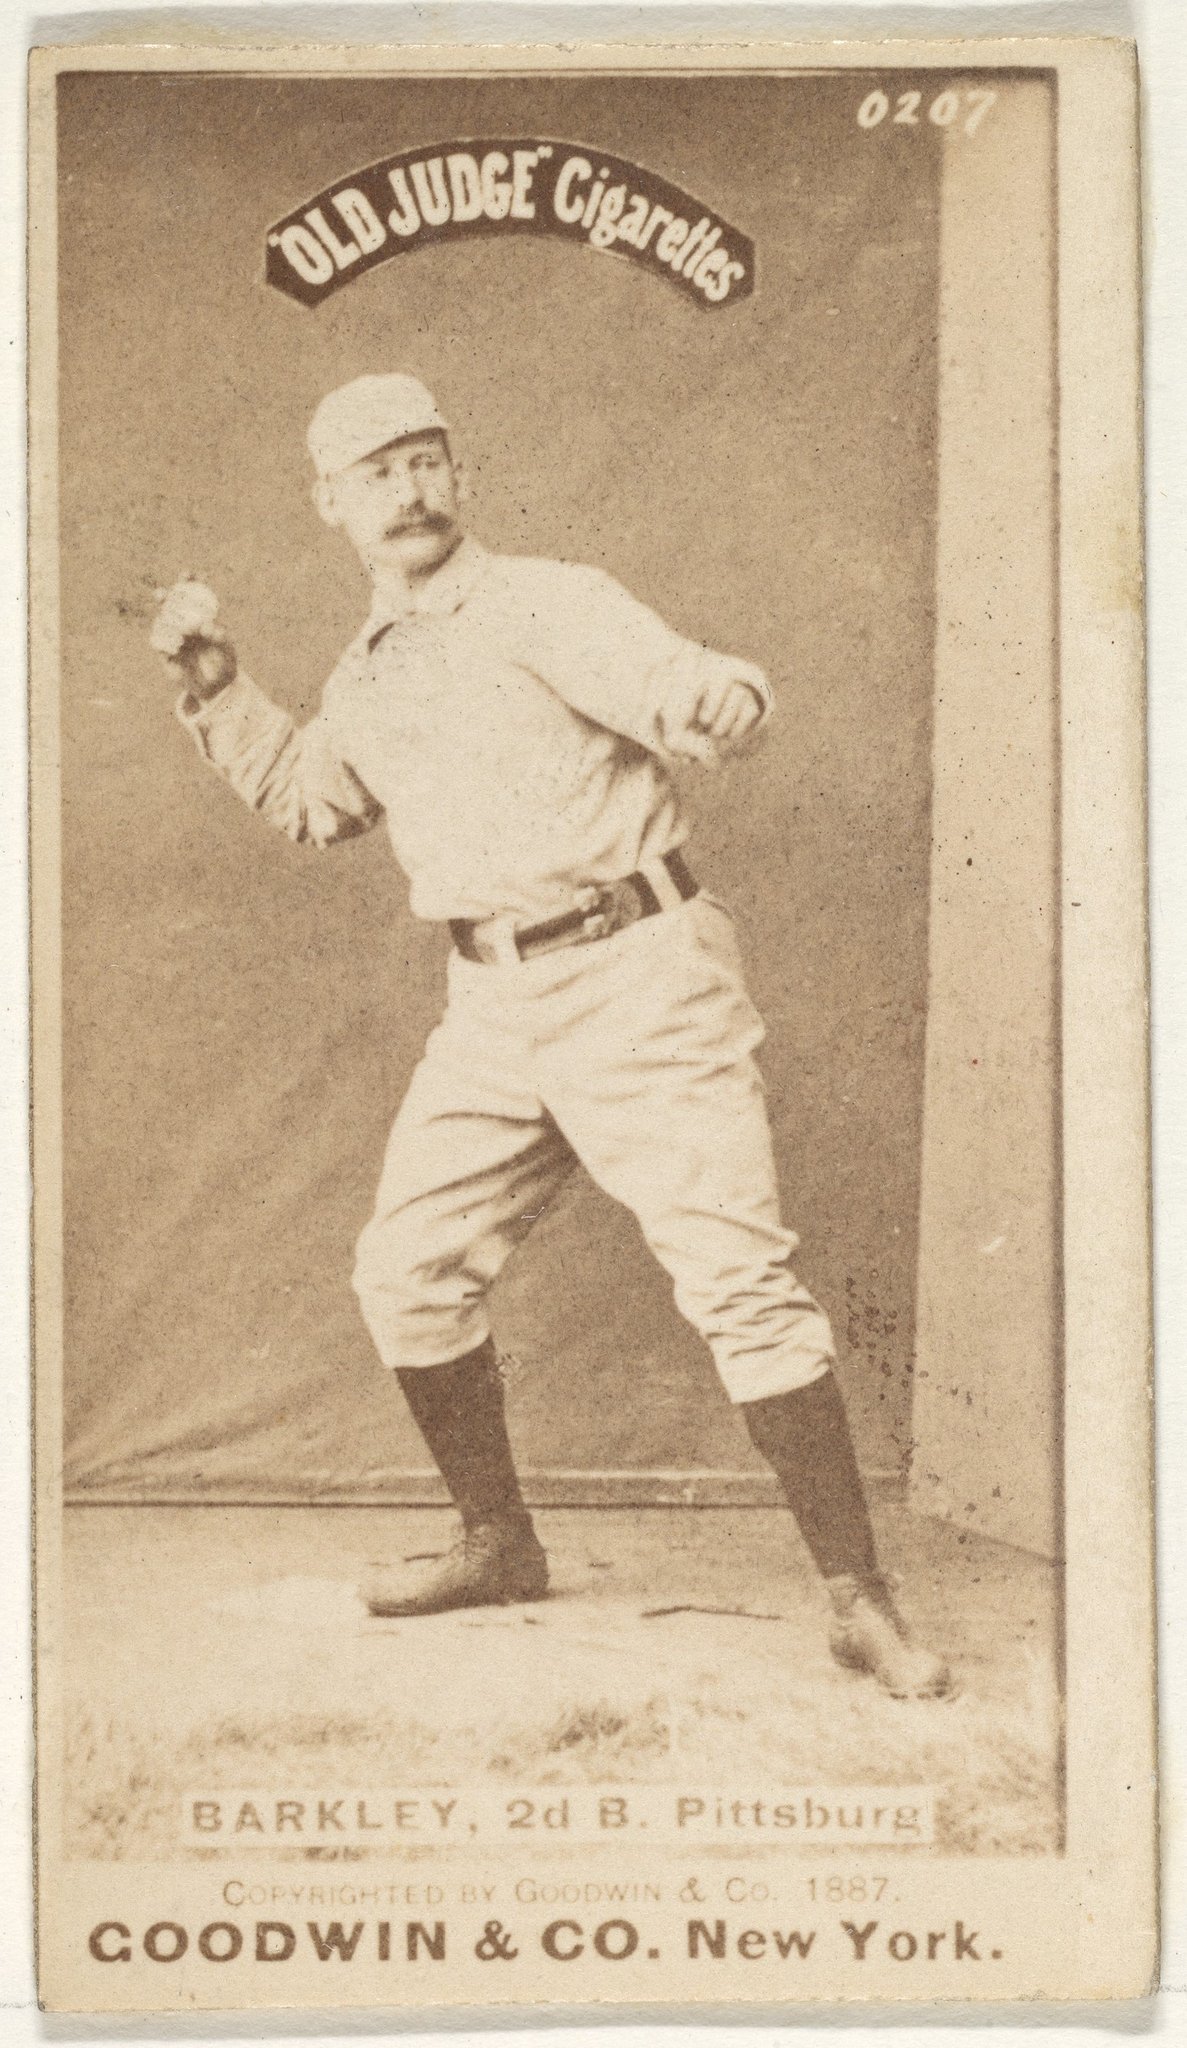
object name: baseball card, photograph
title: Sam Barkley, 2nd Base, Pittsburgh, from the Old Judge series (N172) for Old Judge Cigarettes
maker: goodwin & company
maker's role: publisher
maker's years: 1850-1950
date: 1887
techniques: albumen silver print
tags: men,portraits,baseball,athletes